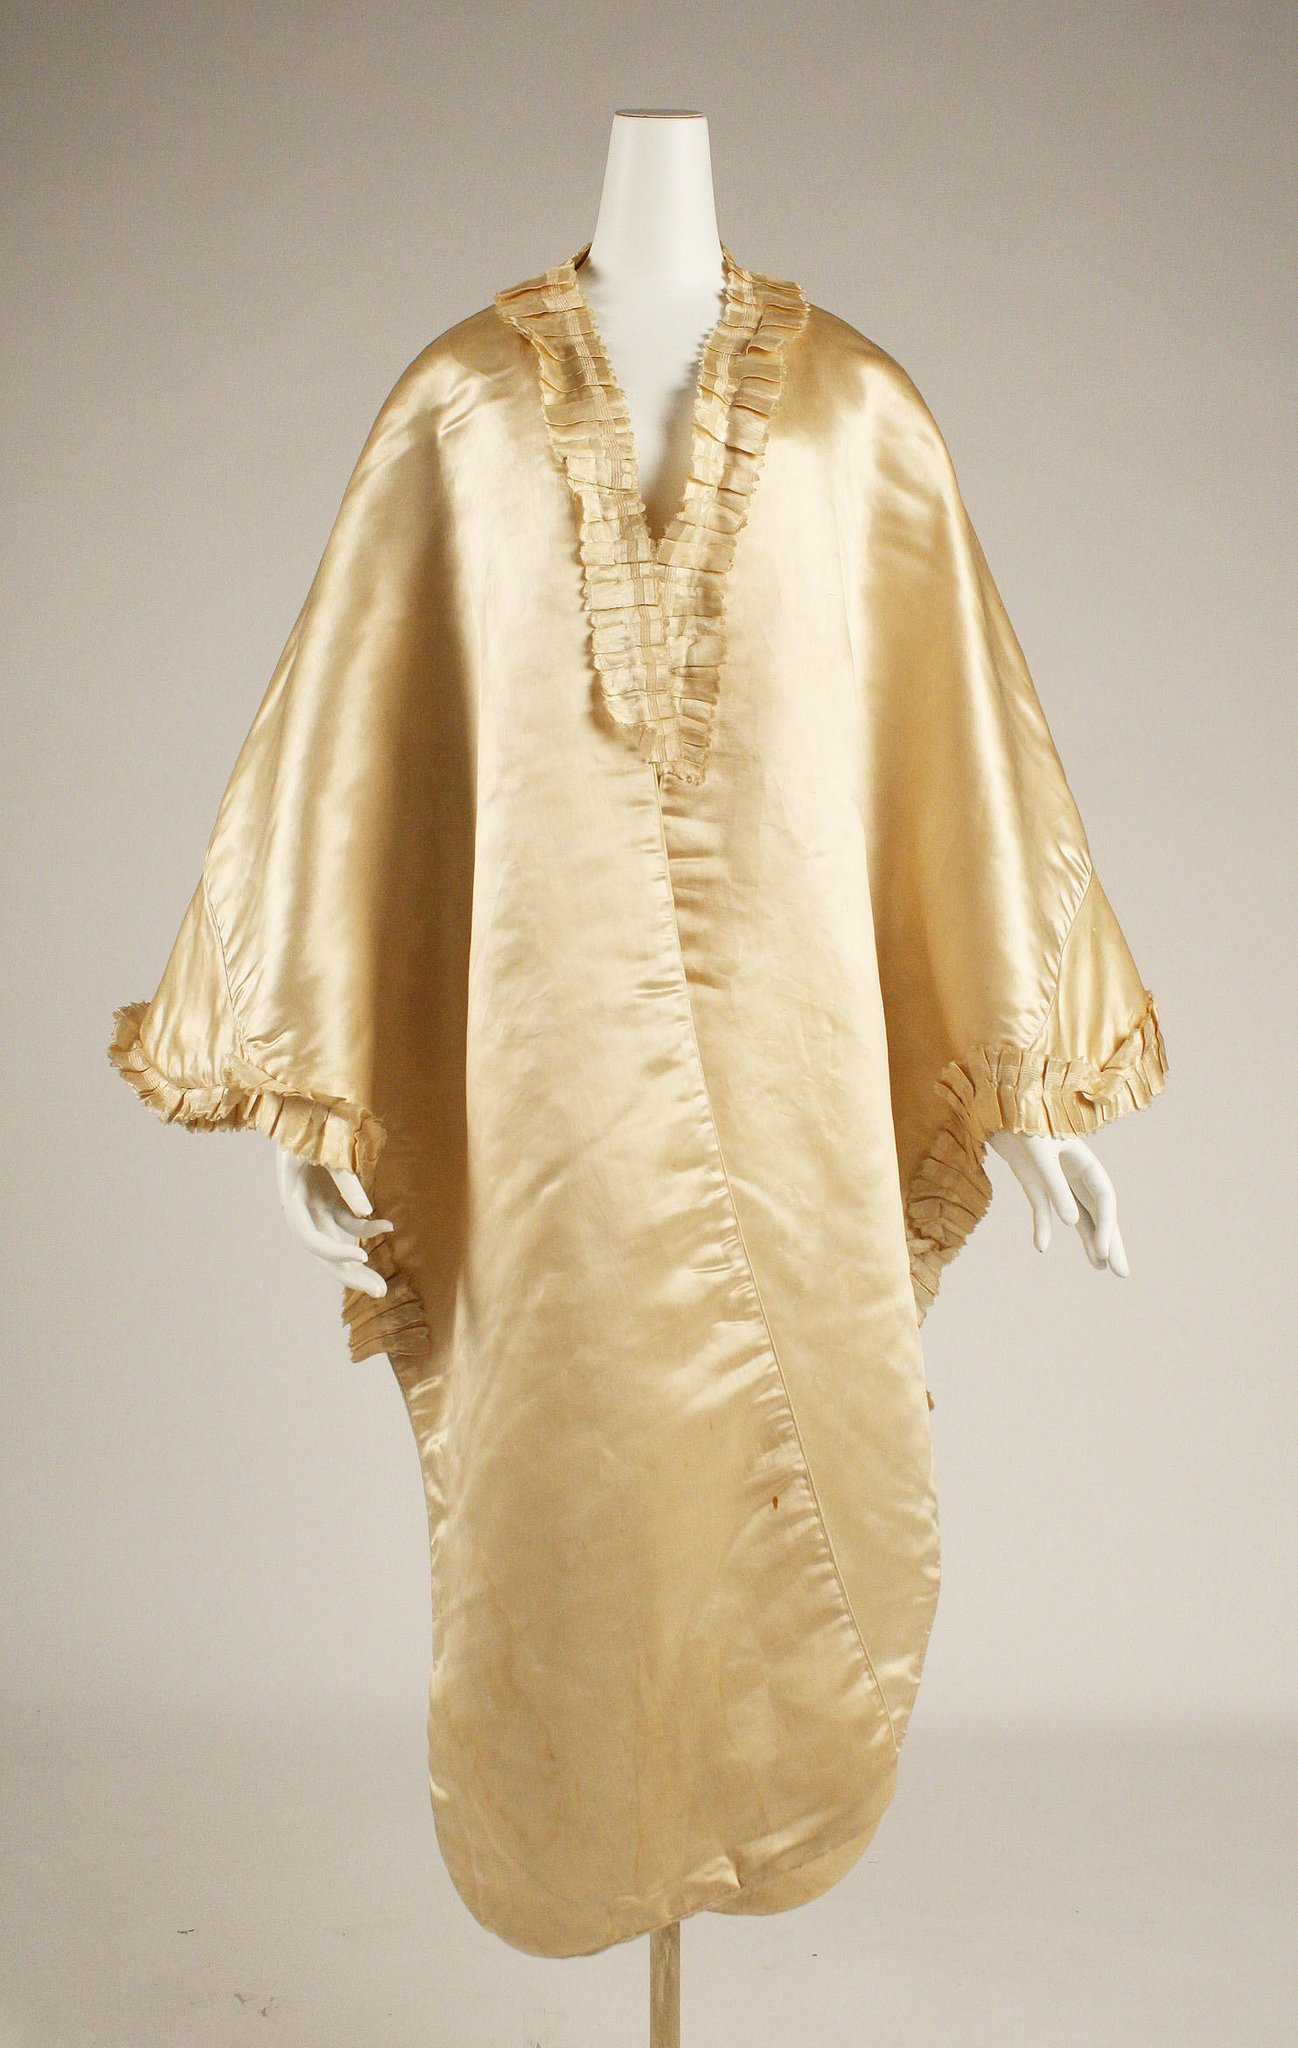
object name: pelerine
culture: european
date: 1815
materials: silk